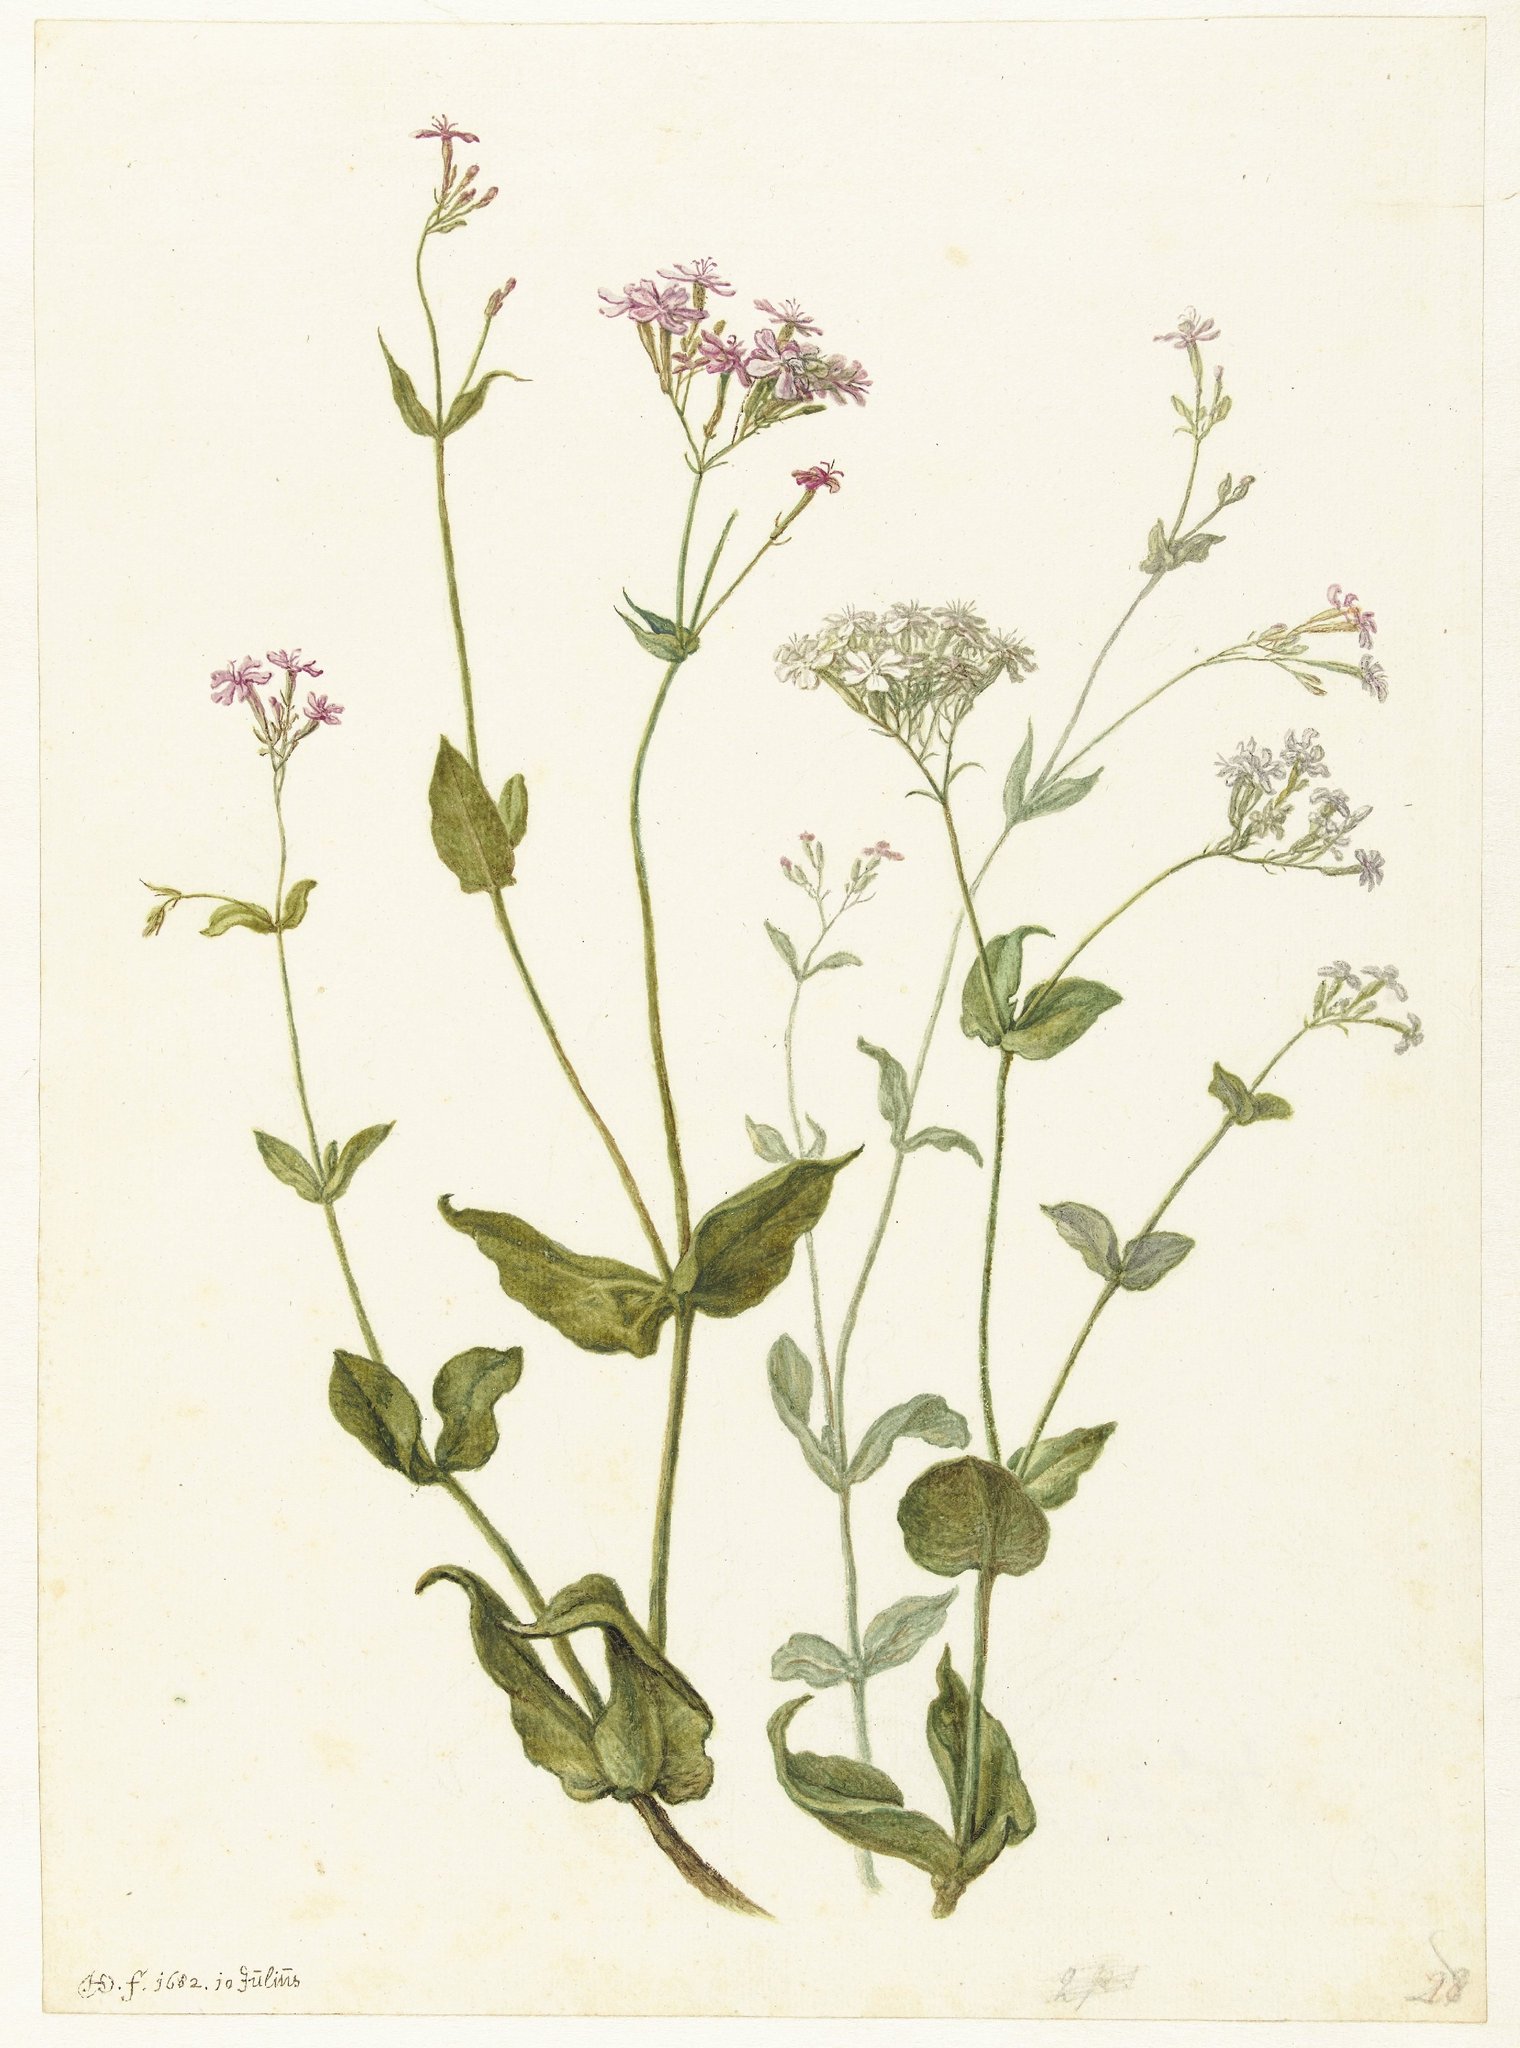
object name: drawing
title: Bladder Senna and Sticky Catchfly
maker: herman saftleven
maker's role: draughtsman, painter, print maker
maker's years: 1609-1685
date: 1682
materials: paper, watercolor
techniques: brush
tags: flowers: viscaria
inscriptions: : ‘Lychnis Viscosa Latifolia. Hore albo et Rubro. vel: Musipula.’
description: Saftleven made these two botanical drawings for Agneta Block, a well-to-do widow. After the death of her first husband, she purchased the Vijverhof country estate near Loenen aan de Vecht. She began cultivating exotic plants there, and commissioned a variety of artists to make drawings of all that blossomed in her garden.